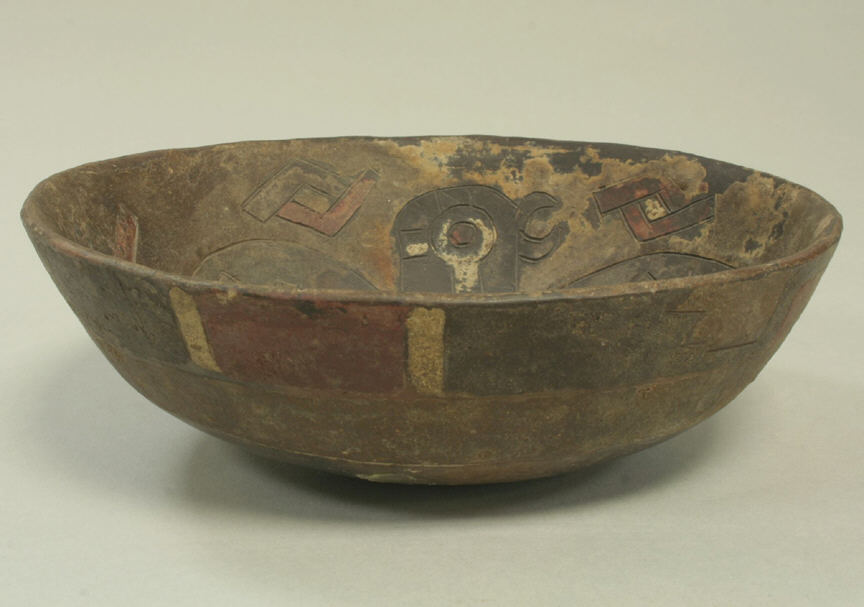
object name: bowl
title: Bowl with Incised Falcoln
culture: paracas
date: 500-301 BCE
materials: ceramic, paint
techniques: firing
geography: peru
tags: falcons